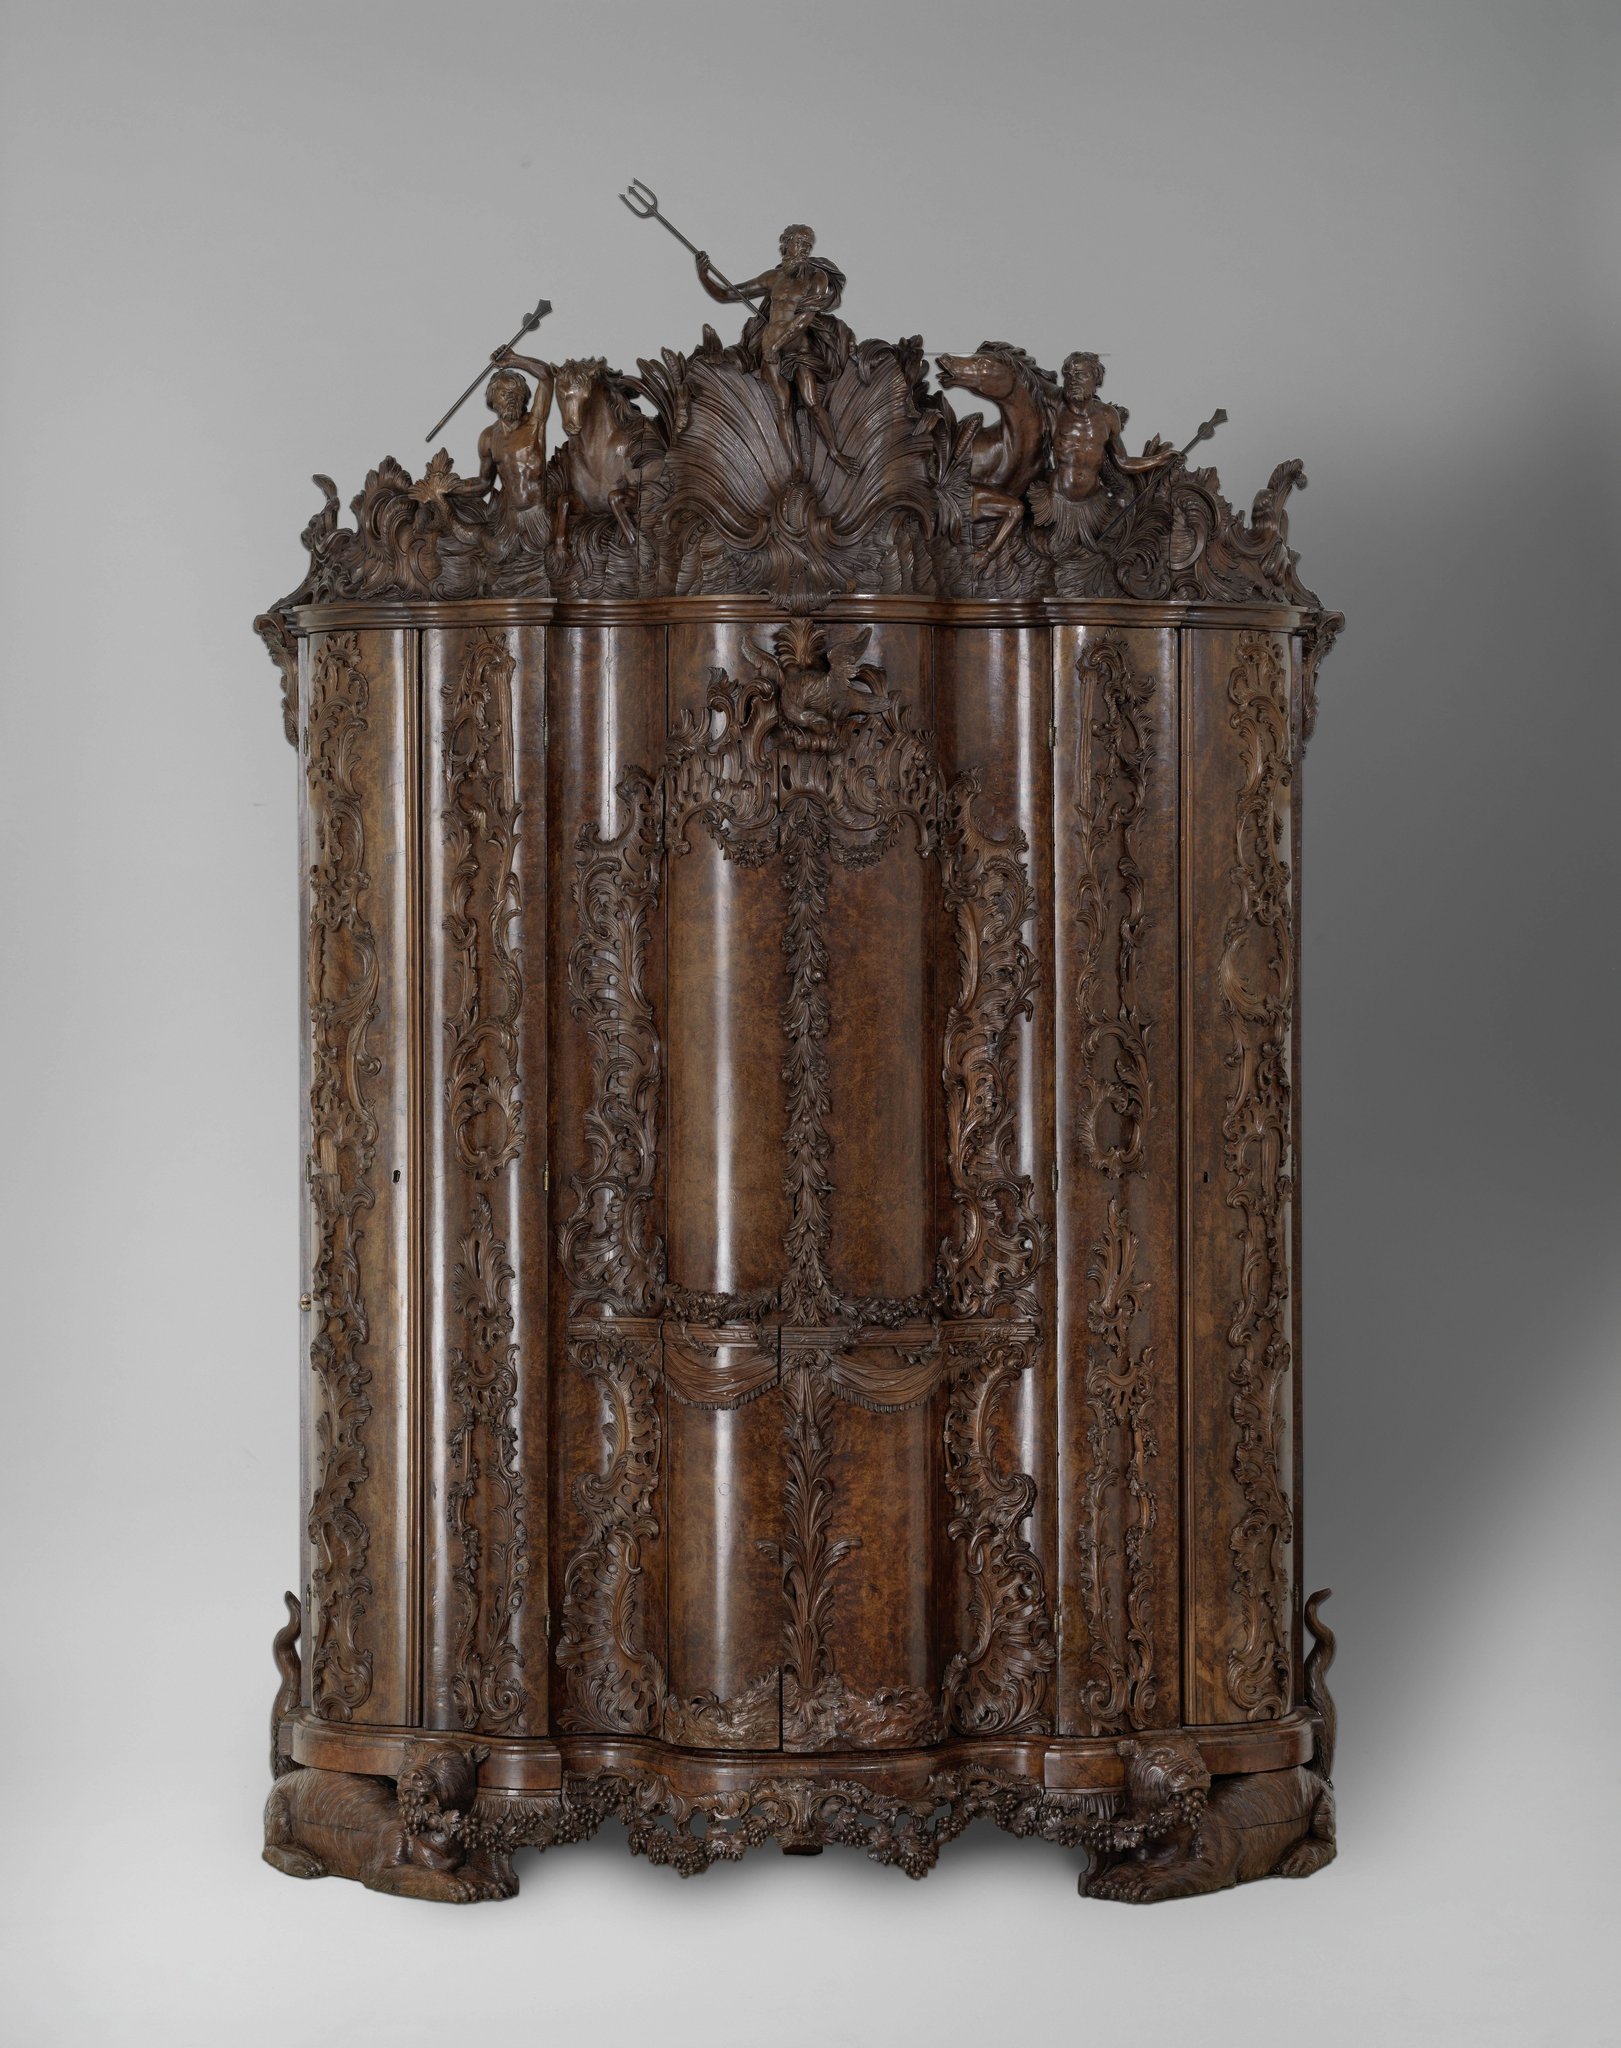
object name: buffet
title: Buffet cupboard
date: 1755-1765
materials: wood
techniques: carved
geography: amsterdam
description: The buffet cupboard is surmounted by the sea god Neptune, accompanied by two tritons, and is supported by two tigers. The ornamental carving is closely related to work done by Frauen in 1744 in a house in Alkmaar. In making this piece, which was also richly adorned with carving on the inside, the sculptor played a more important role than the cabinetmaker.